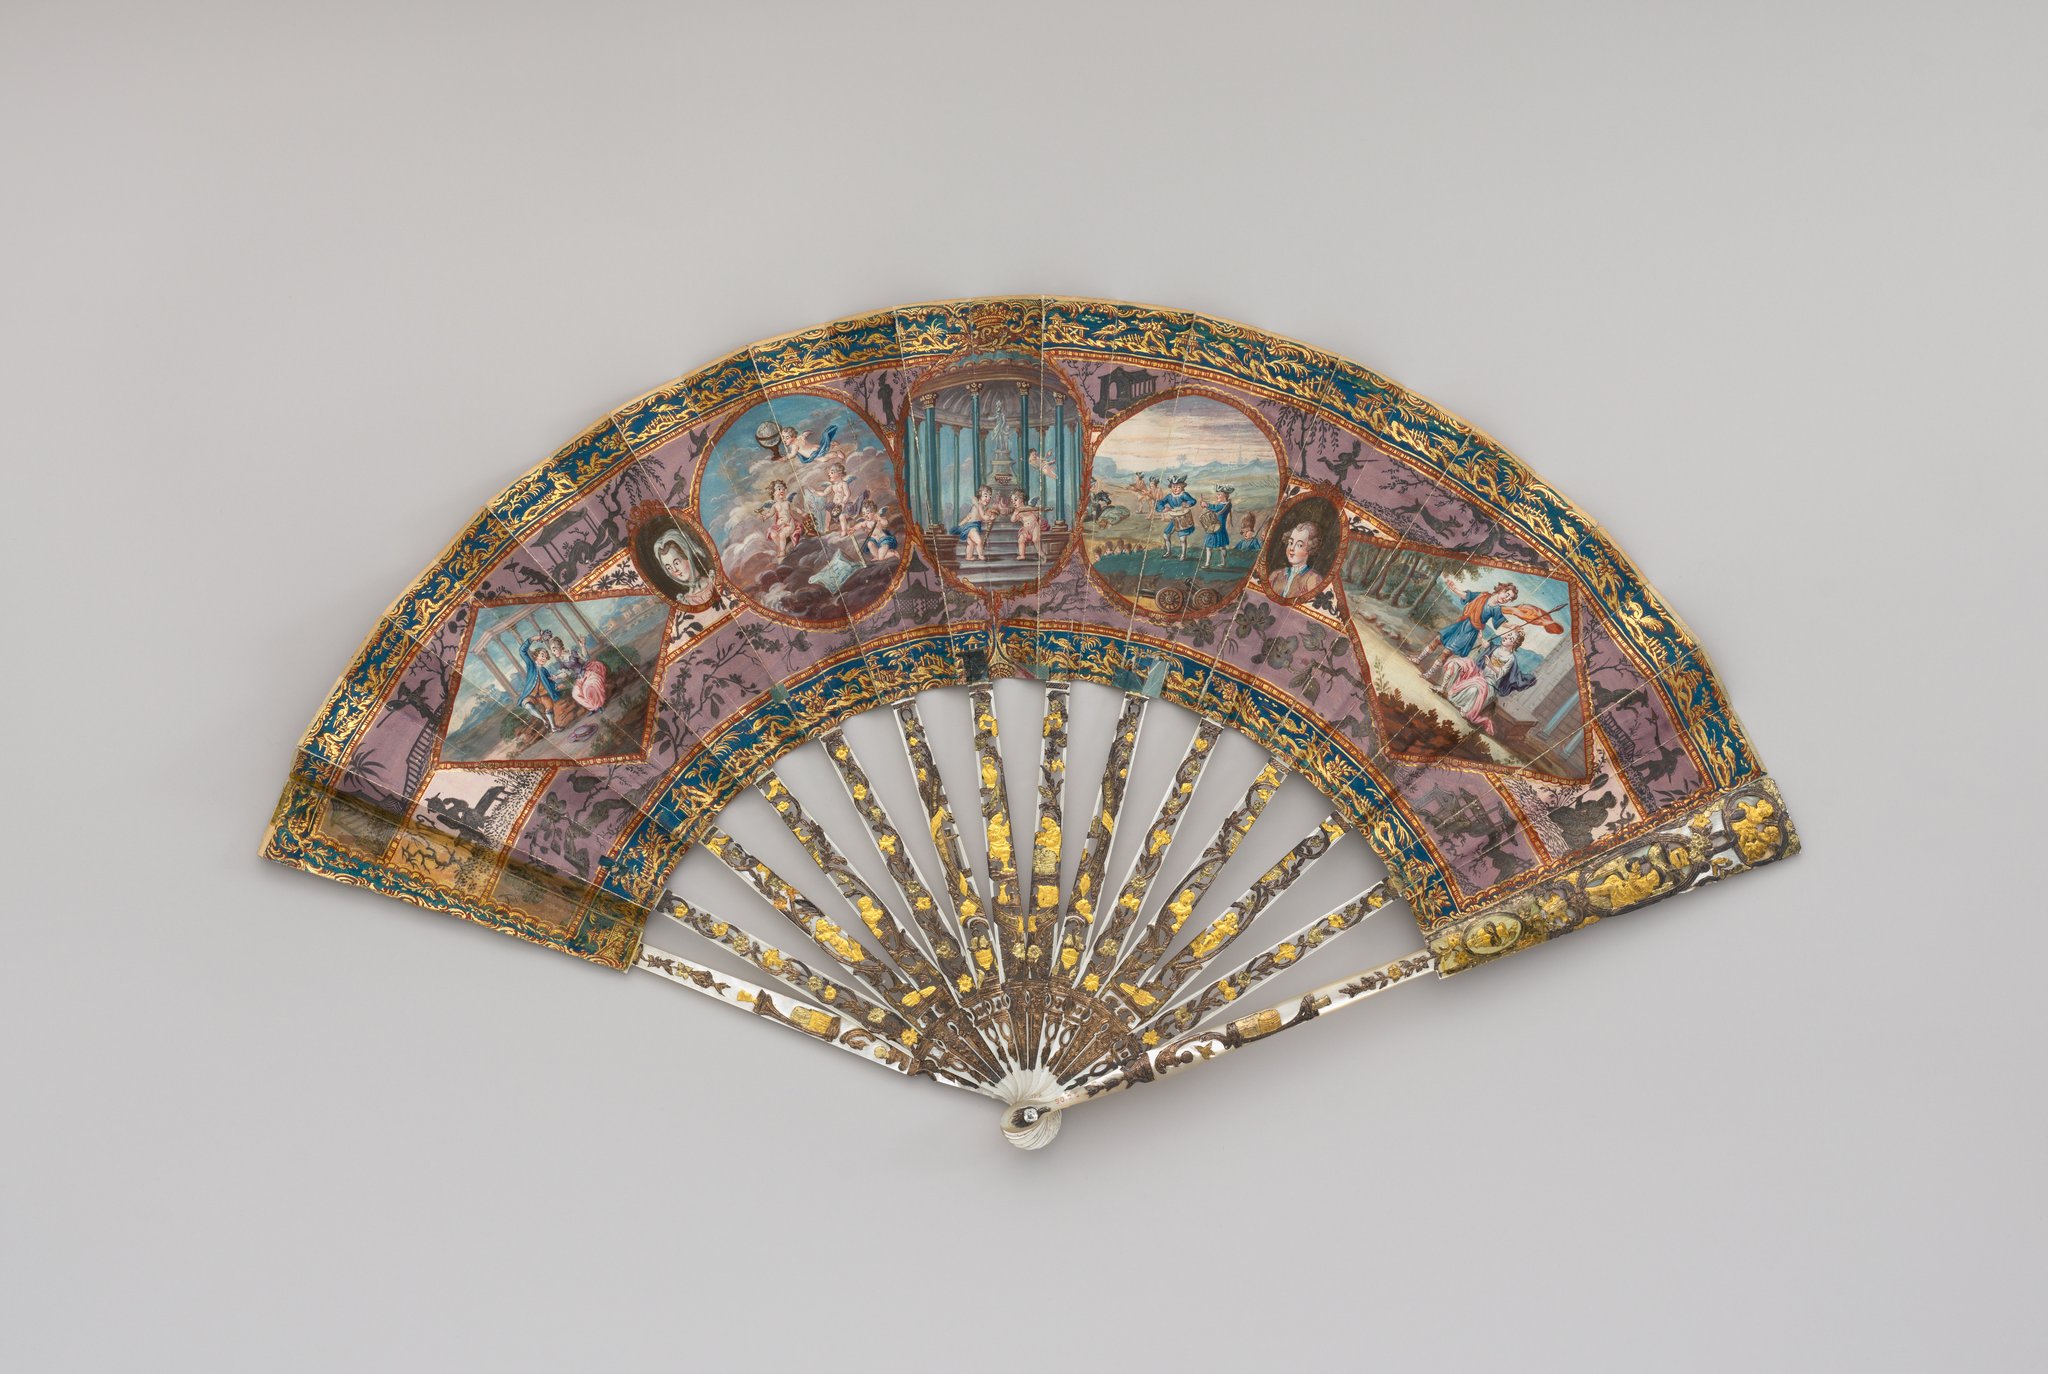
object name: fan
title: Wedding (or betrothal) fan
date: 1770-1790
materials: gold, mother of pearl, paint, paper, silver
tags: men,women,putti